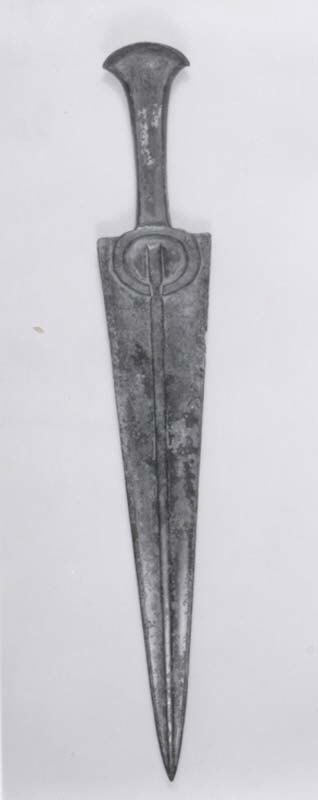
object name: dagger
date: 1000-801 BCE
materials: bronze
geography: northwestern iran, caspian region